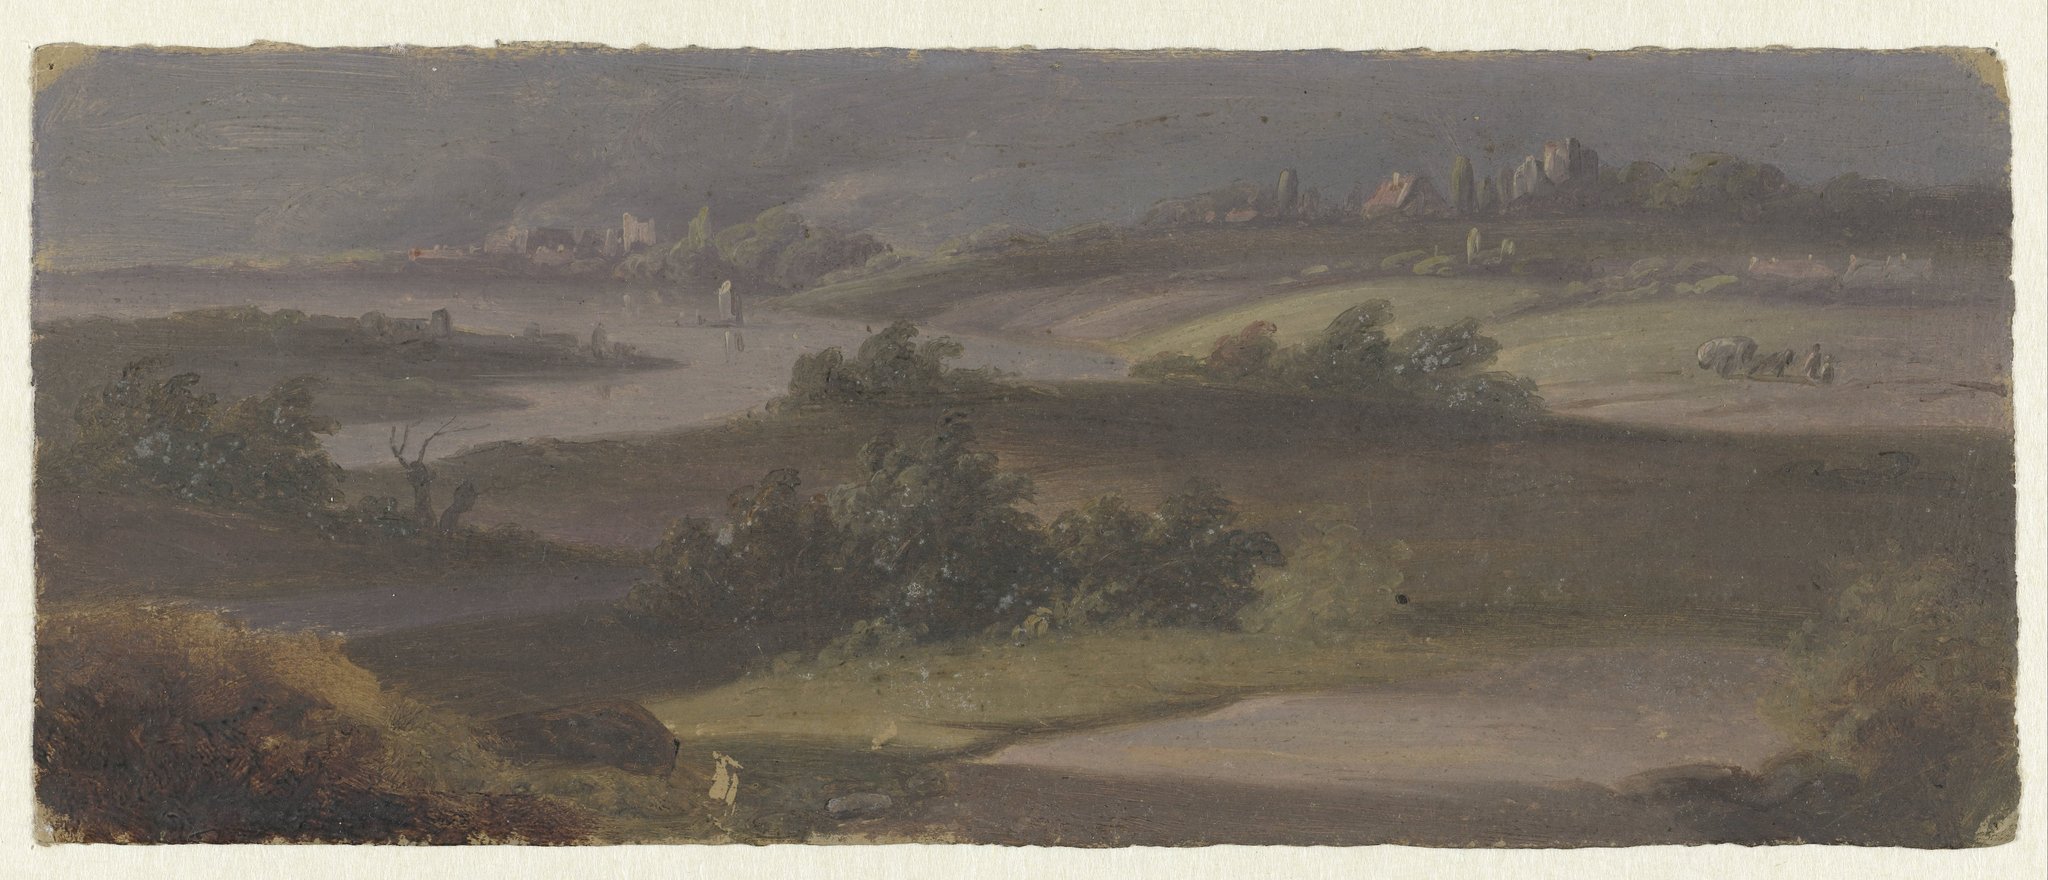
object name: drawing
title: Landschap met rivierbocht en donkere lucht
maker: Anonymous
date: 1600-1800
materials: oil, paper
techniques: brush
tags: landscapes with waters, waterscapes, seascapes (in the temperate zone)